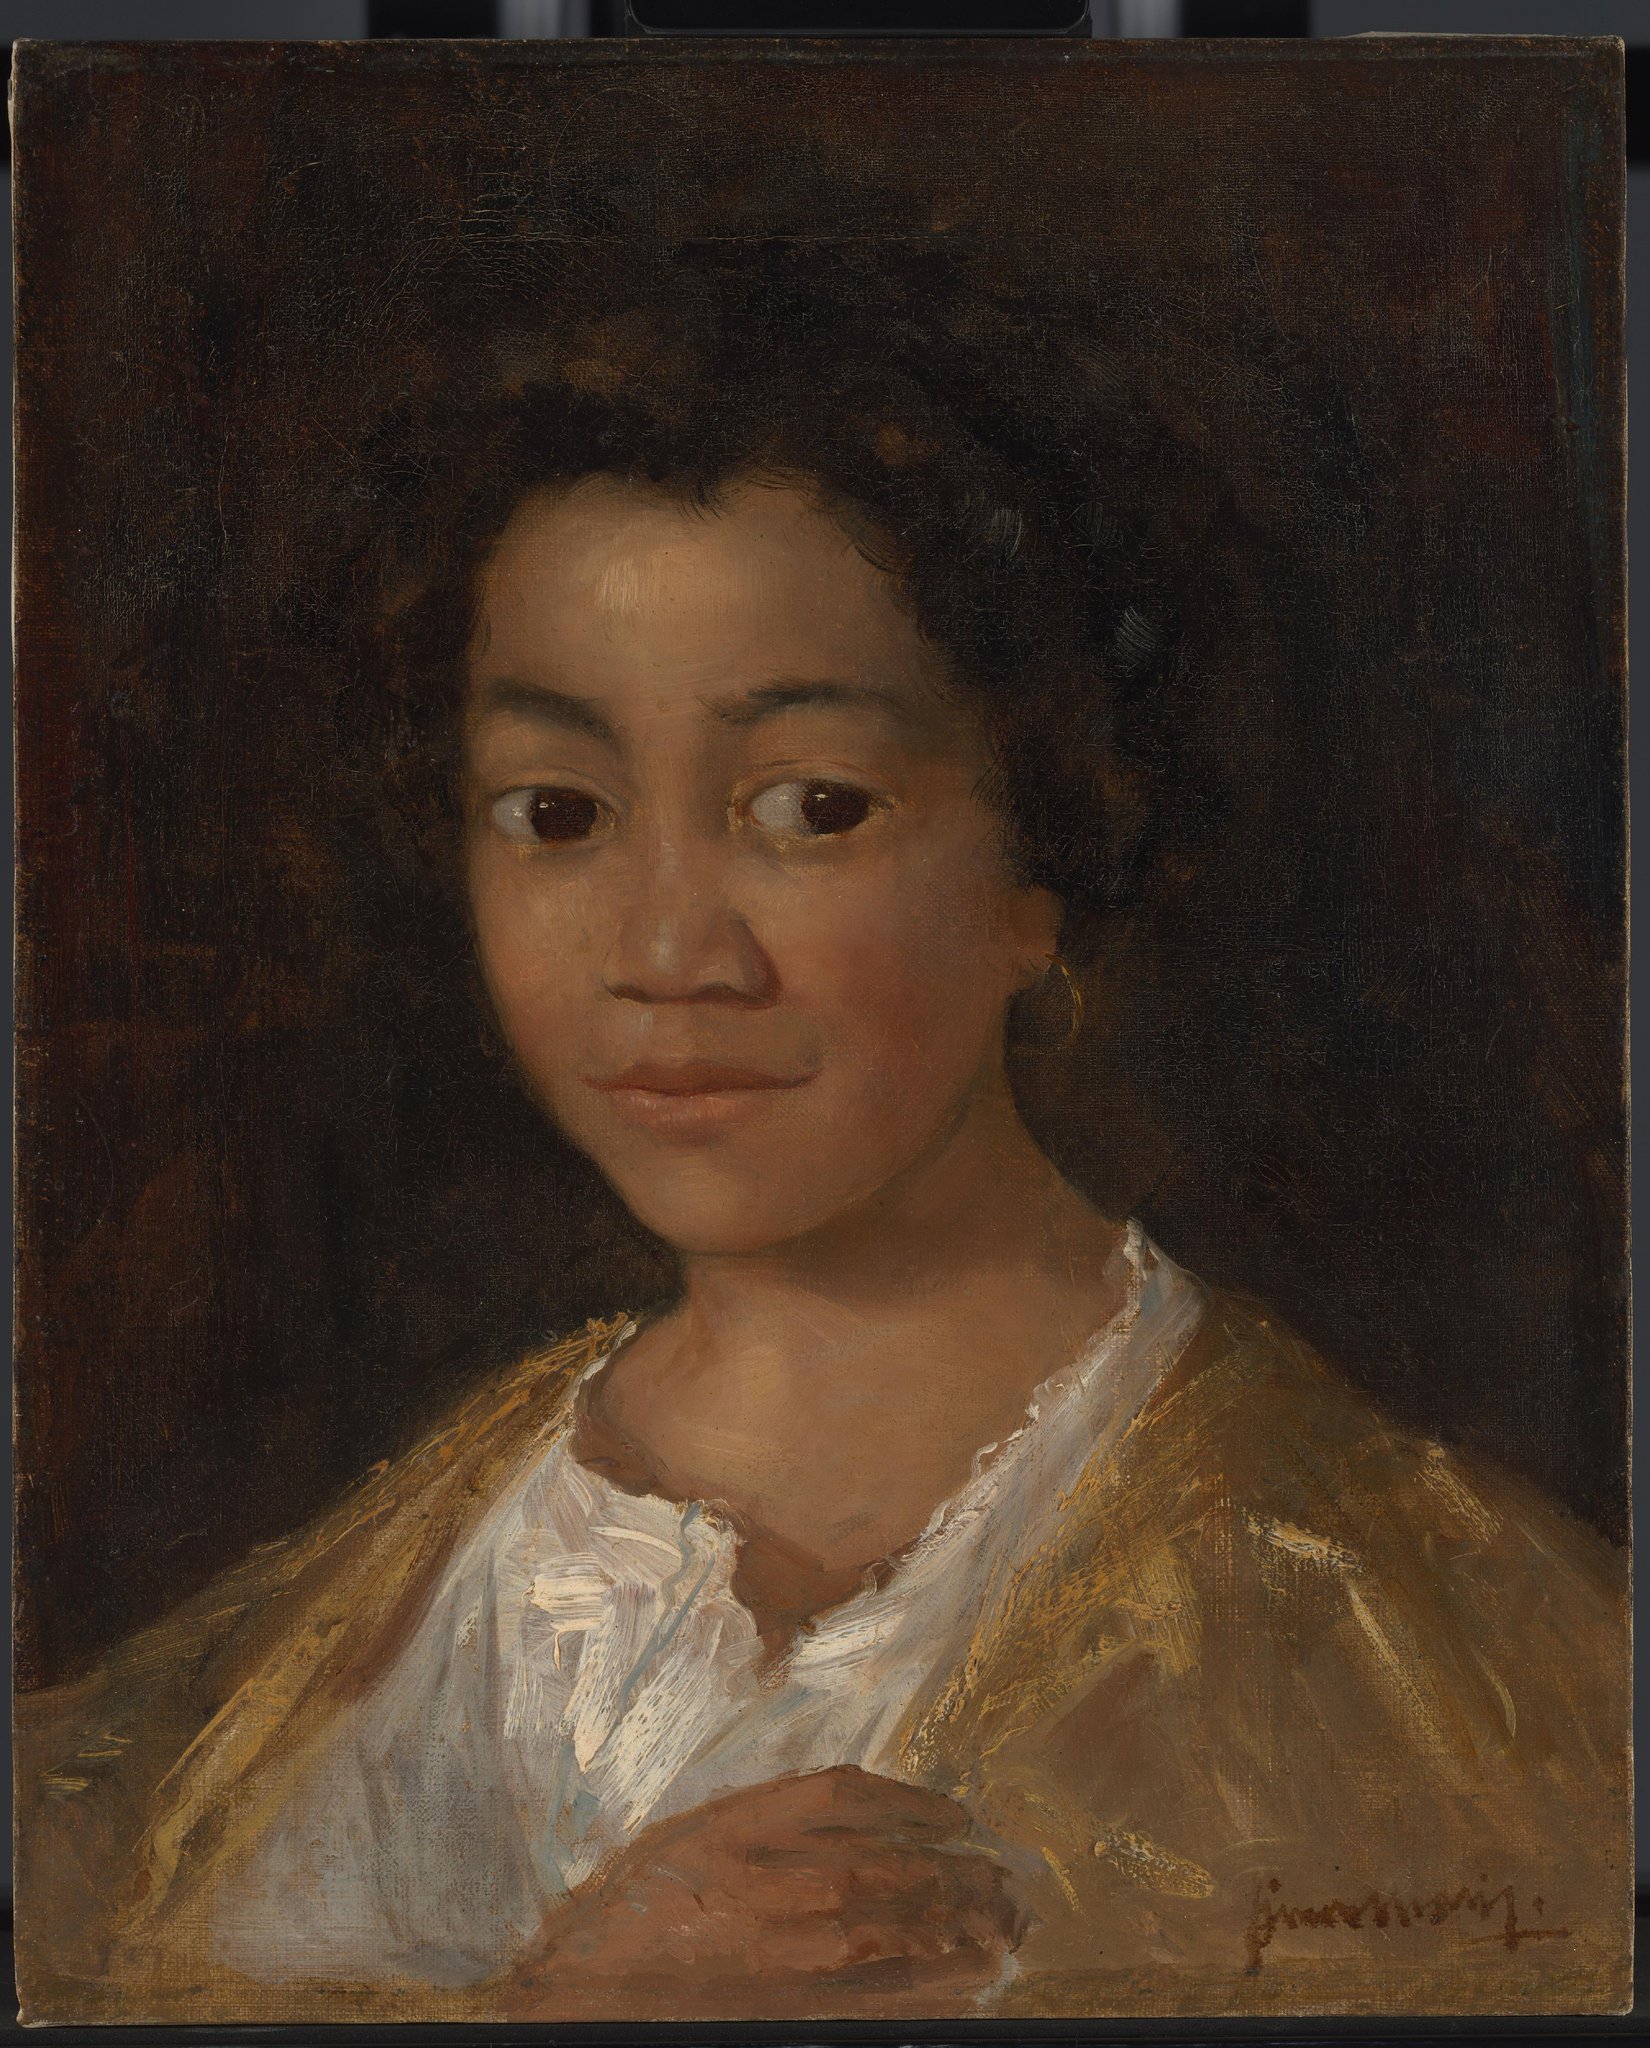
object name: painting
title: Portret van model, getiteld Isabella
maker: simon maris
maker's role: painter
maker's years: 1873-1935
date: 1906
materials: oil, paint, panel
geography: amsterdam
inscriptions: label: ‘Amsterdamse lijstenmaker H. Gonkel’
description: Het model is centraal in het beeldvlak geplaatst tegen een donkere achtergrond. Zij is gekleed in een wit hemd en draagt daarover een goudkleurige omslagdoek of mantel, die ze met haar rechterhand vasthoudt. Zij draagt links een gouden oorring.